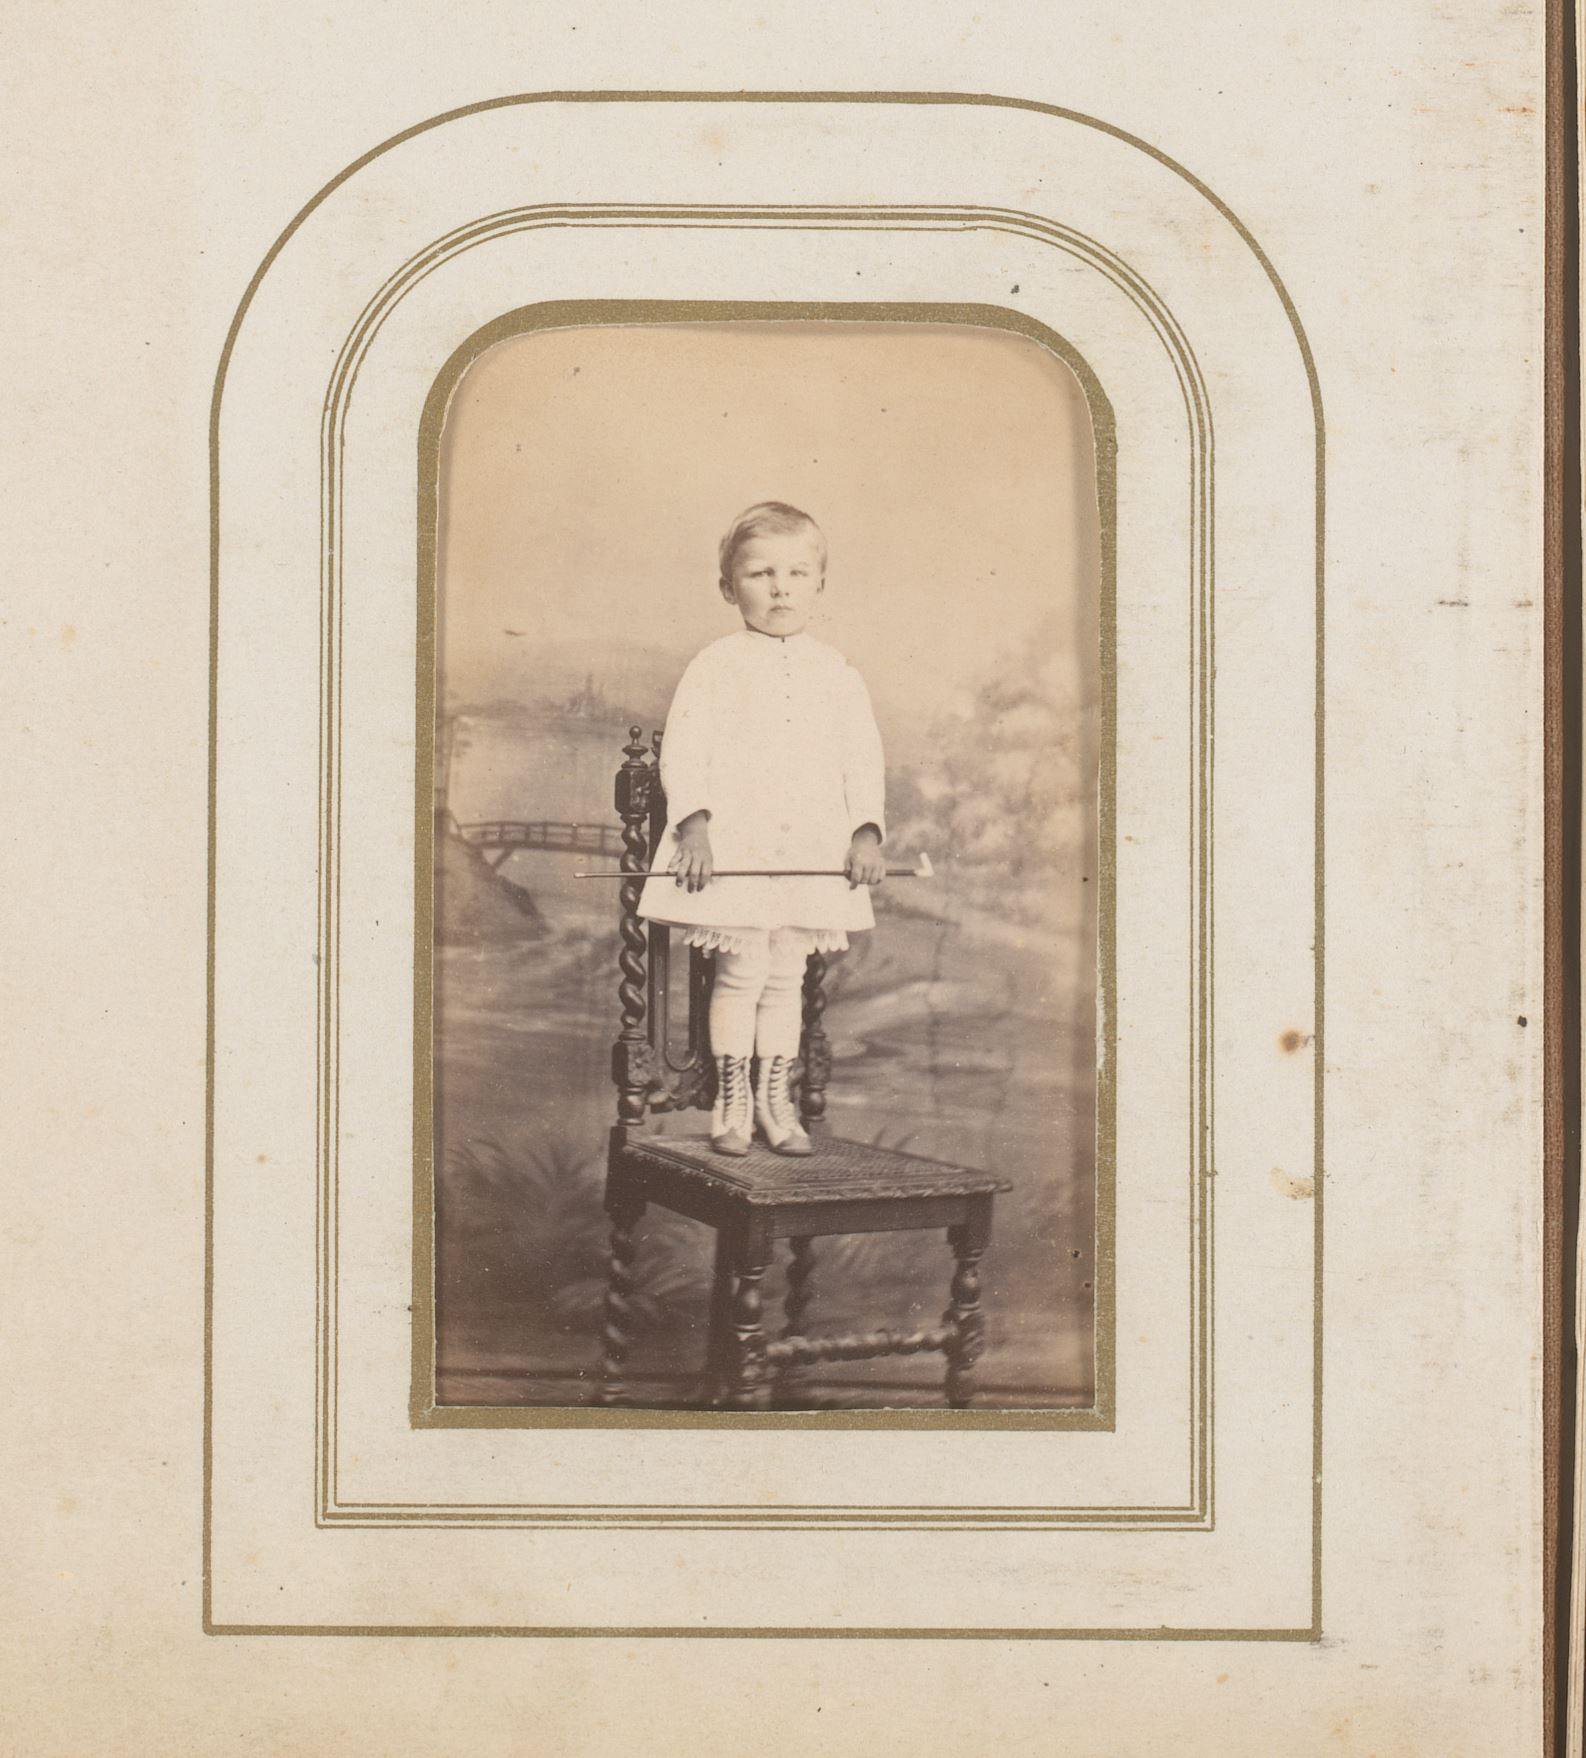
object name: album leaf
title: Portret van een jongen met wandelstok, staand op een stoel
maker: charles lambert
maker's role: fotograaf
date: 1860-1880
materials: cardboard, photographic support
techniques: albumen print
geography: arlon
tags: standing figure, boy (child between toddler and youth), walking-stick, staff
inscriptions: inscription: ‘Photographie Parisienne/ Charles Lambert/ Rue de l Athlénée/ Arlon/ Tous les clichés sont conservé’